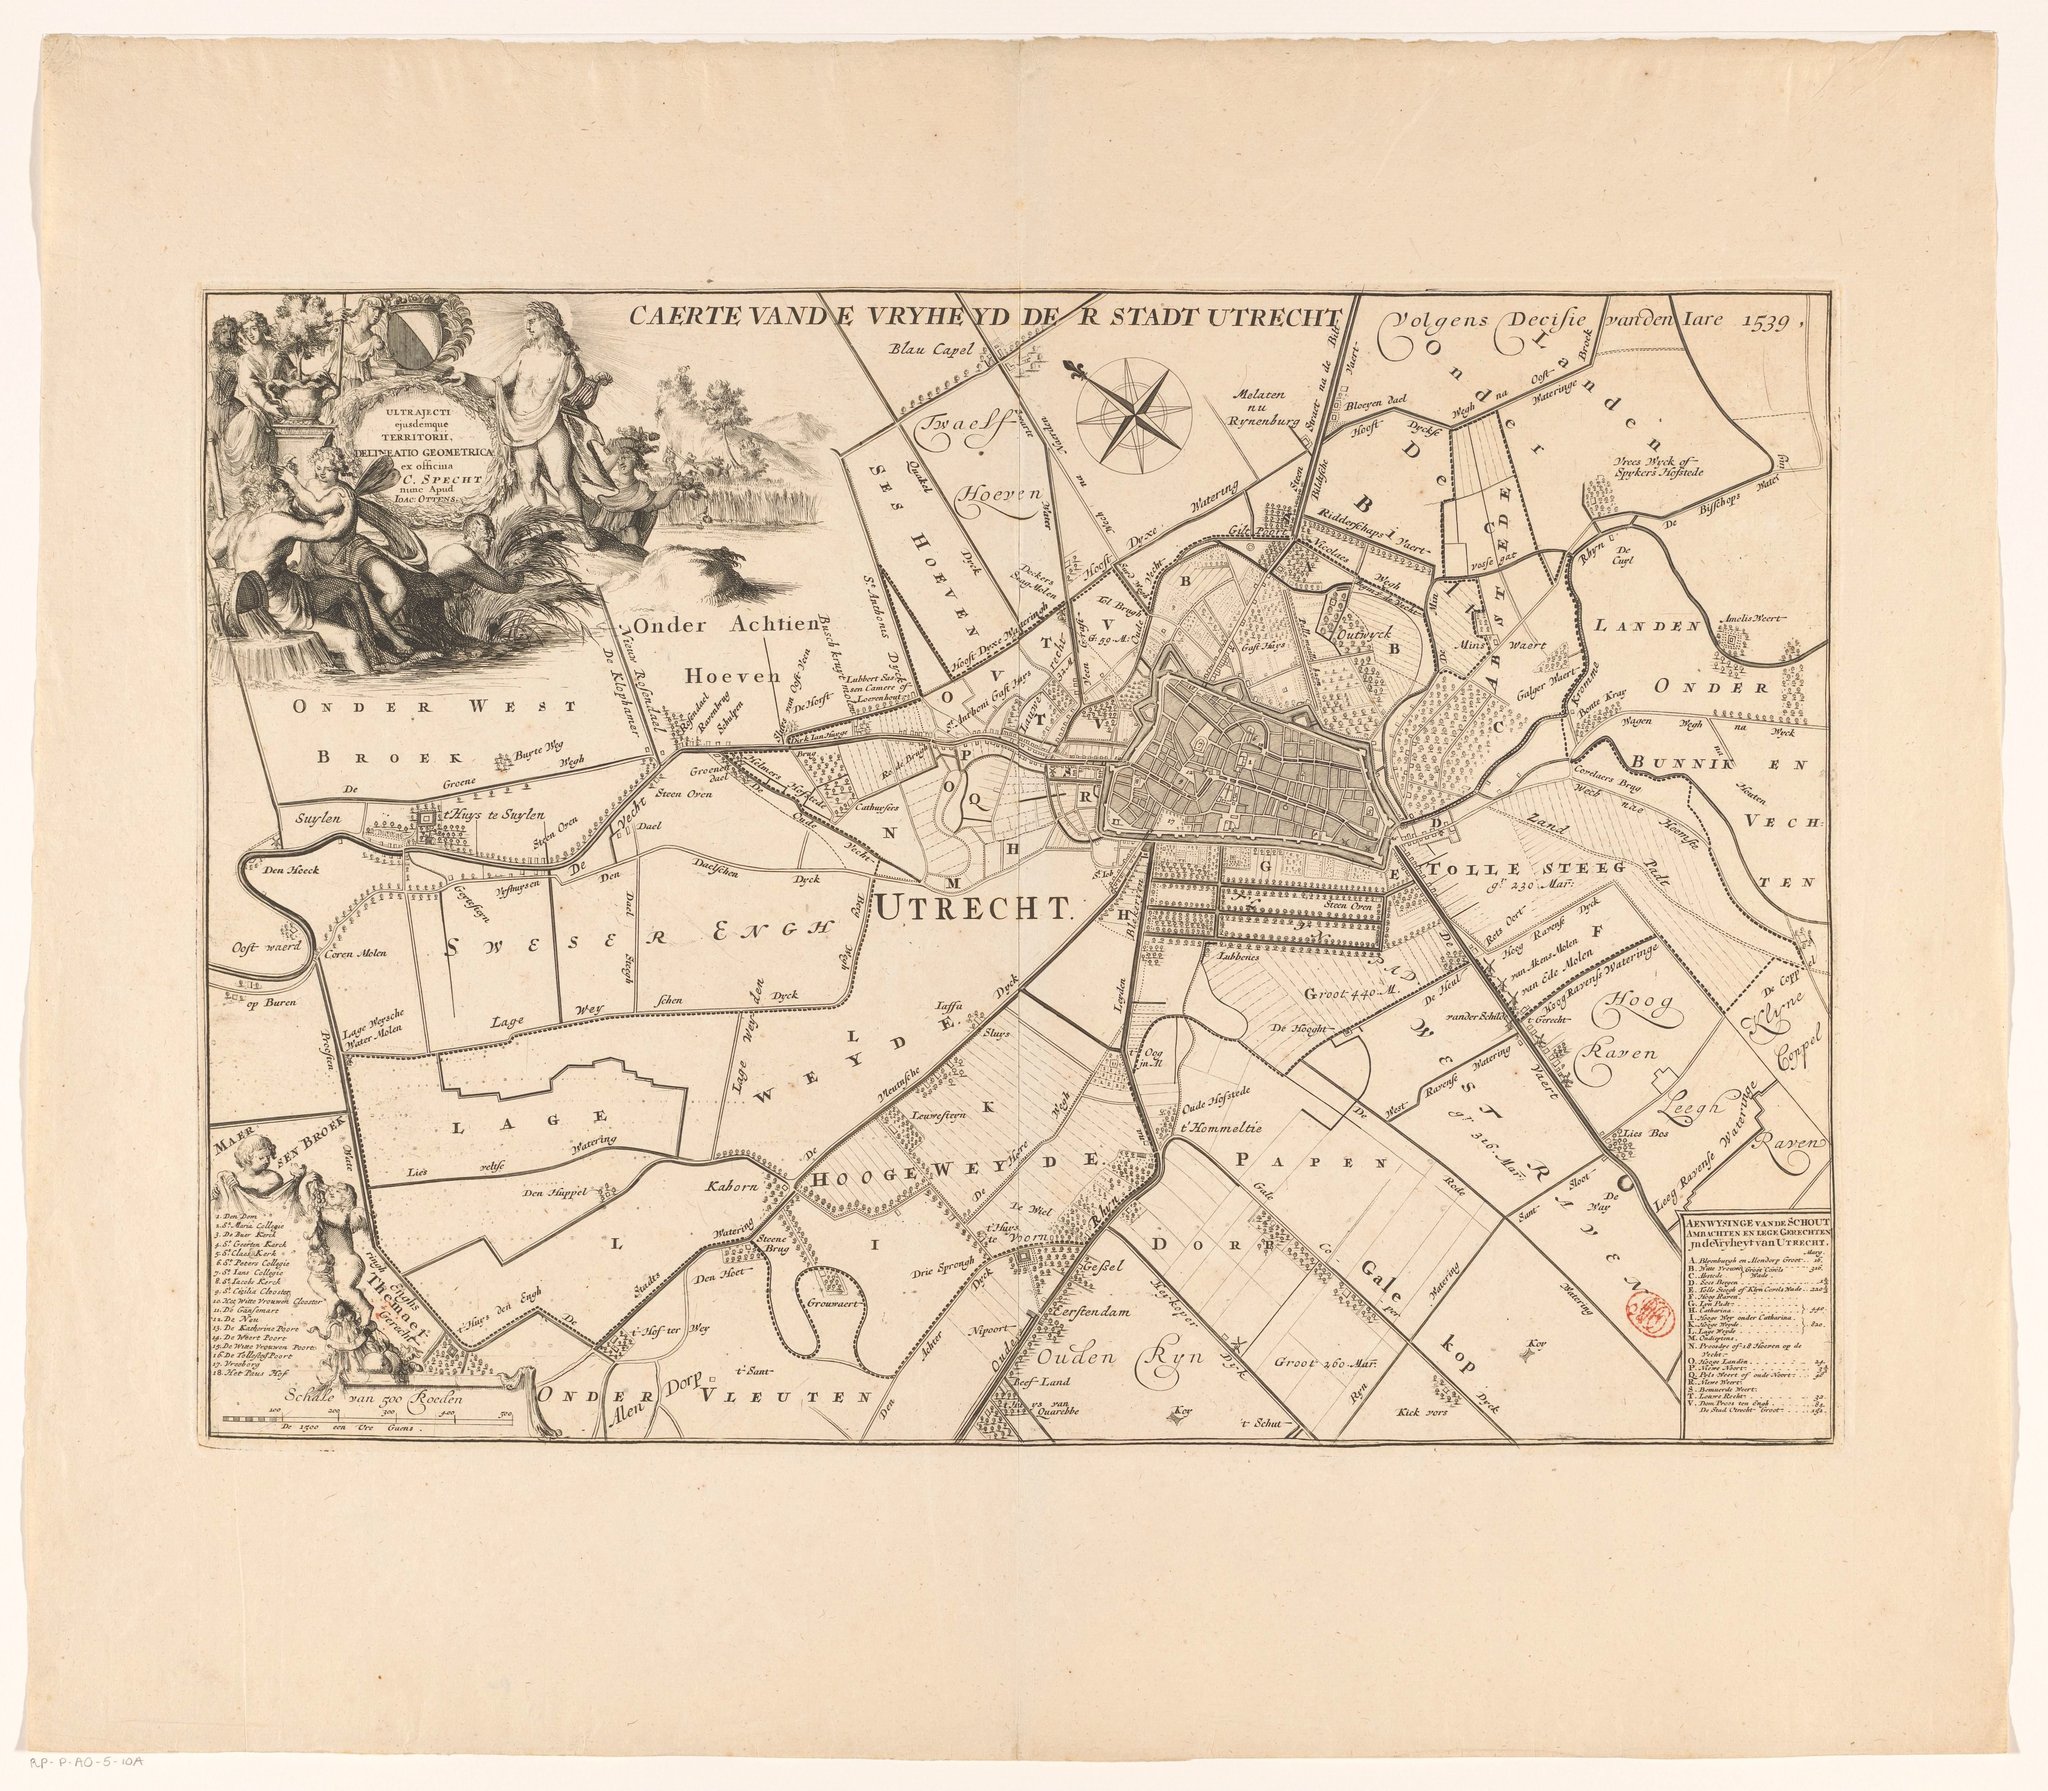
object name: print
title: Kaart van de stadsvrijheid Utrecht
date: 1696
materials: paper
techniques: engraving, etching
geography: amsterdam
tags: coat of arms (as symbol of the state, etc.), (story of) diana (artemis), maps of separate countries or regions, (story of) apollo (phoebus), (story of) minerva (pallas, athena), farmers, river-gods, maps of cities, utrecht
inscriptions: collector's mark: Lugt 195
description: Deze plattegrond geeft de Utrechtse stadsvrijheid weer (het gebied waarover de stad jurisdictie had) naar de situatie in 1539. De grens van de jurisdictie is aangegeven met een stippellijn. Linksboven een cartouche met de Latijnse titel en daarboven het wapen van de stad. Om de cartouche verschillende mythologische figuren waaronder Diana en Minerva (beiden links van het wapen op de achtergrond), Apollo en een riviergod. Links op de achtergrond landbouwers aan het werk. Linksonder een legenda met de gebouwen in de stad en een schaalstok: Schale van 500 roeden. Rechtsonder een legenda met de schoutambachten en lage gerechten.